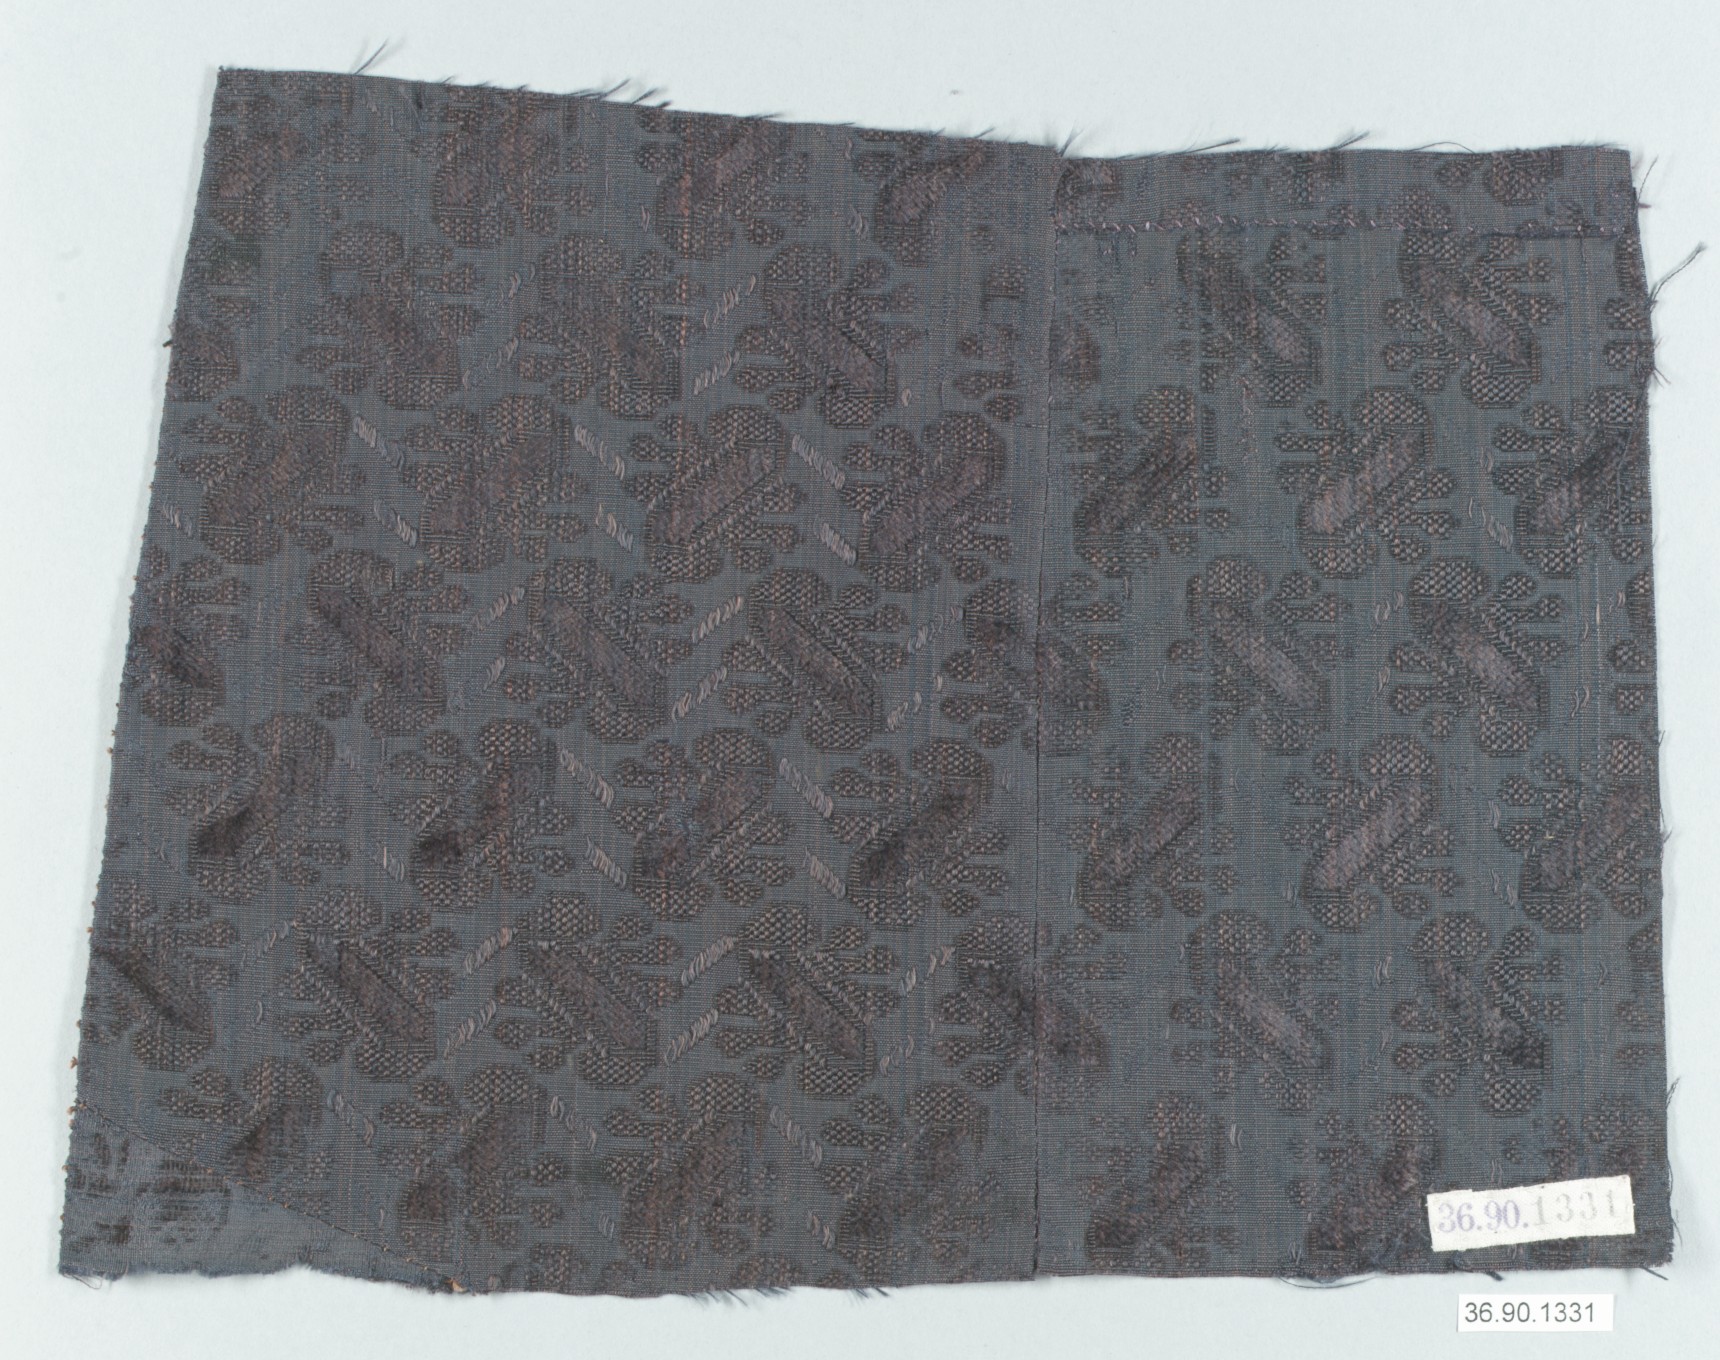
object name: piece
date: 1501-1700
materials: silk